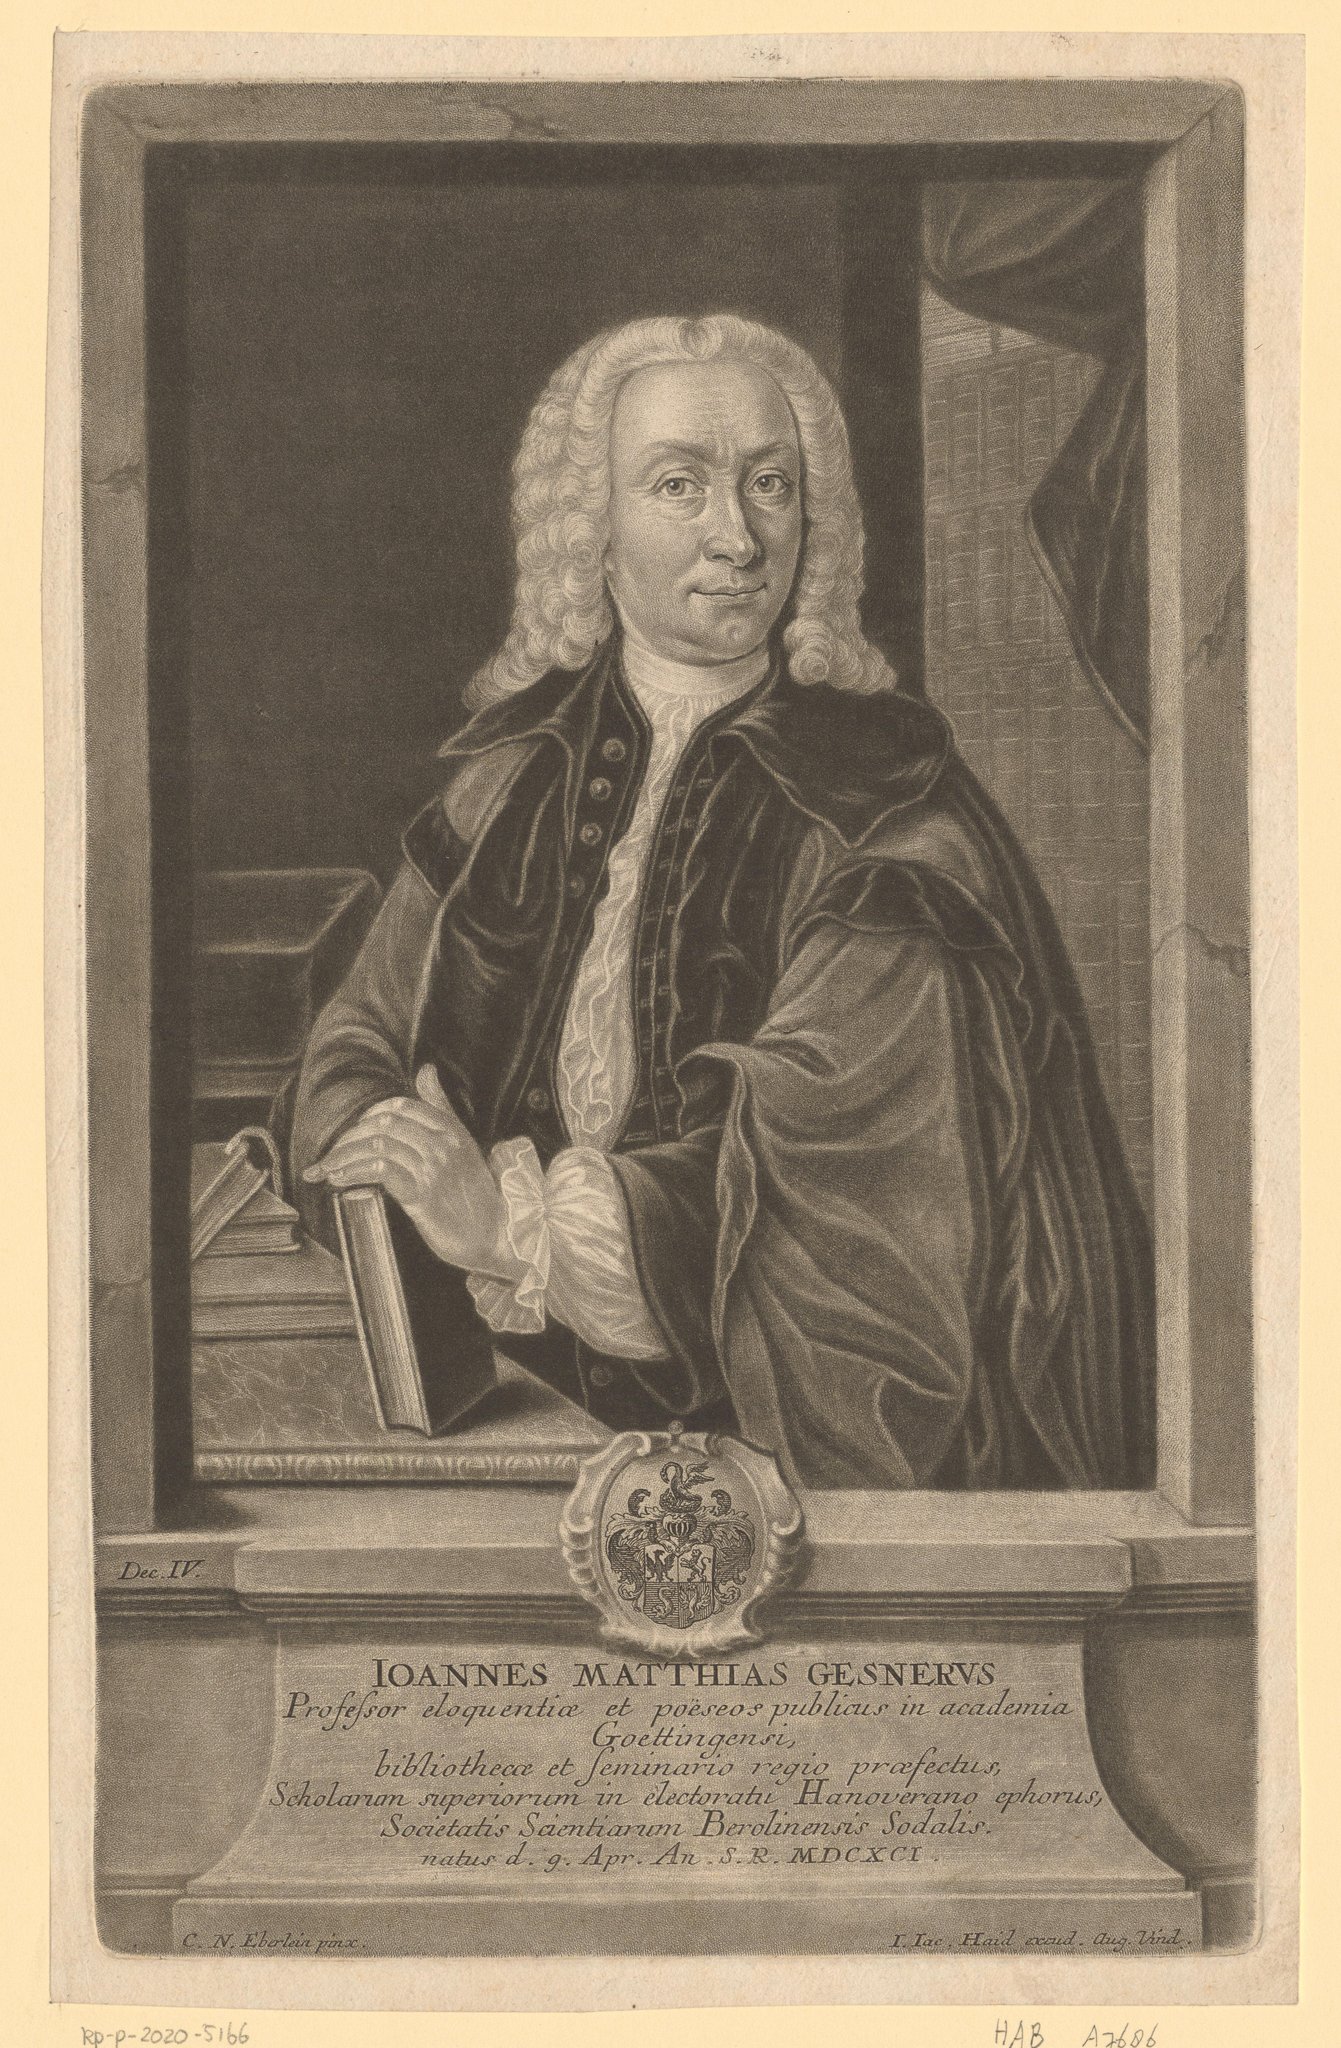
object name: book illustration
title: Portret van Johann Matthias Gesner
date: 1755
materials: paper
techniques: engraving, etching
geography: augsburg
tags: johann matthias gesner, language ~ philology (+ portrait of scholar, scientist), historical persons, armorial bearing, heraldry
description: Prent uit: Brucker, Johann Jakob. Bilder-Sal heutiges Tages lebender und durch Gelahrtheit berühmter Schriftsteller (...). Augsburg: Johann Jacob Haid, 1744.